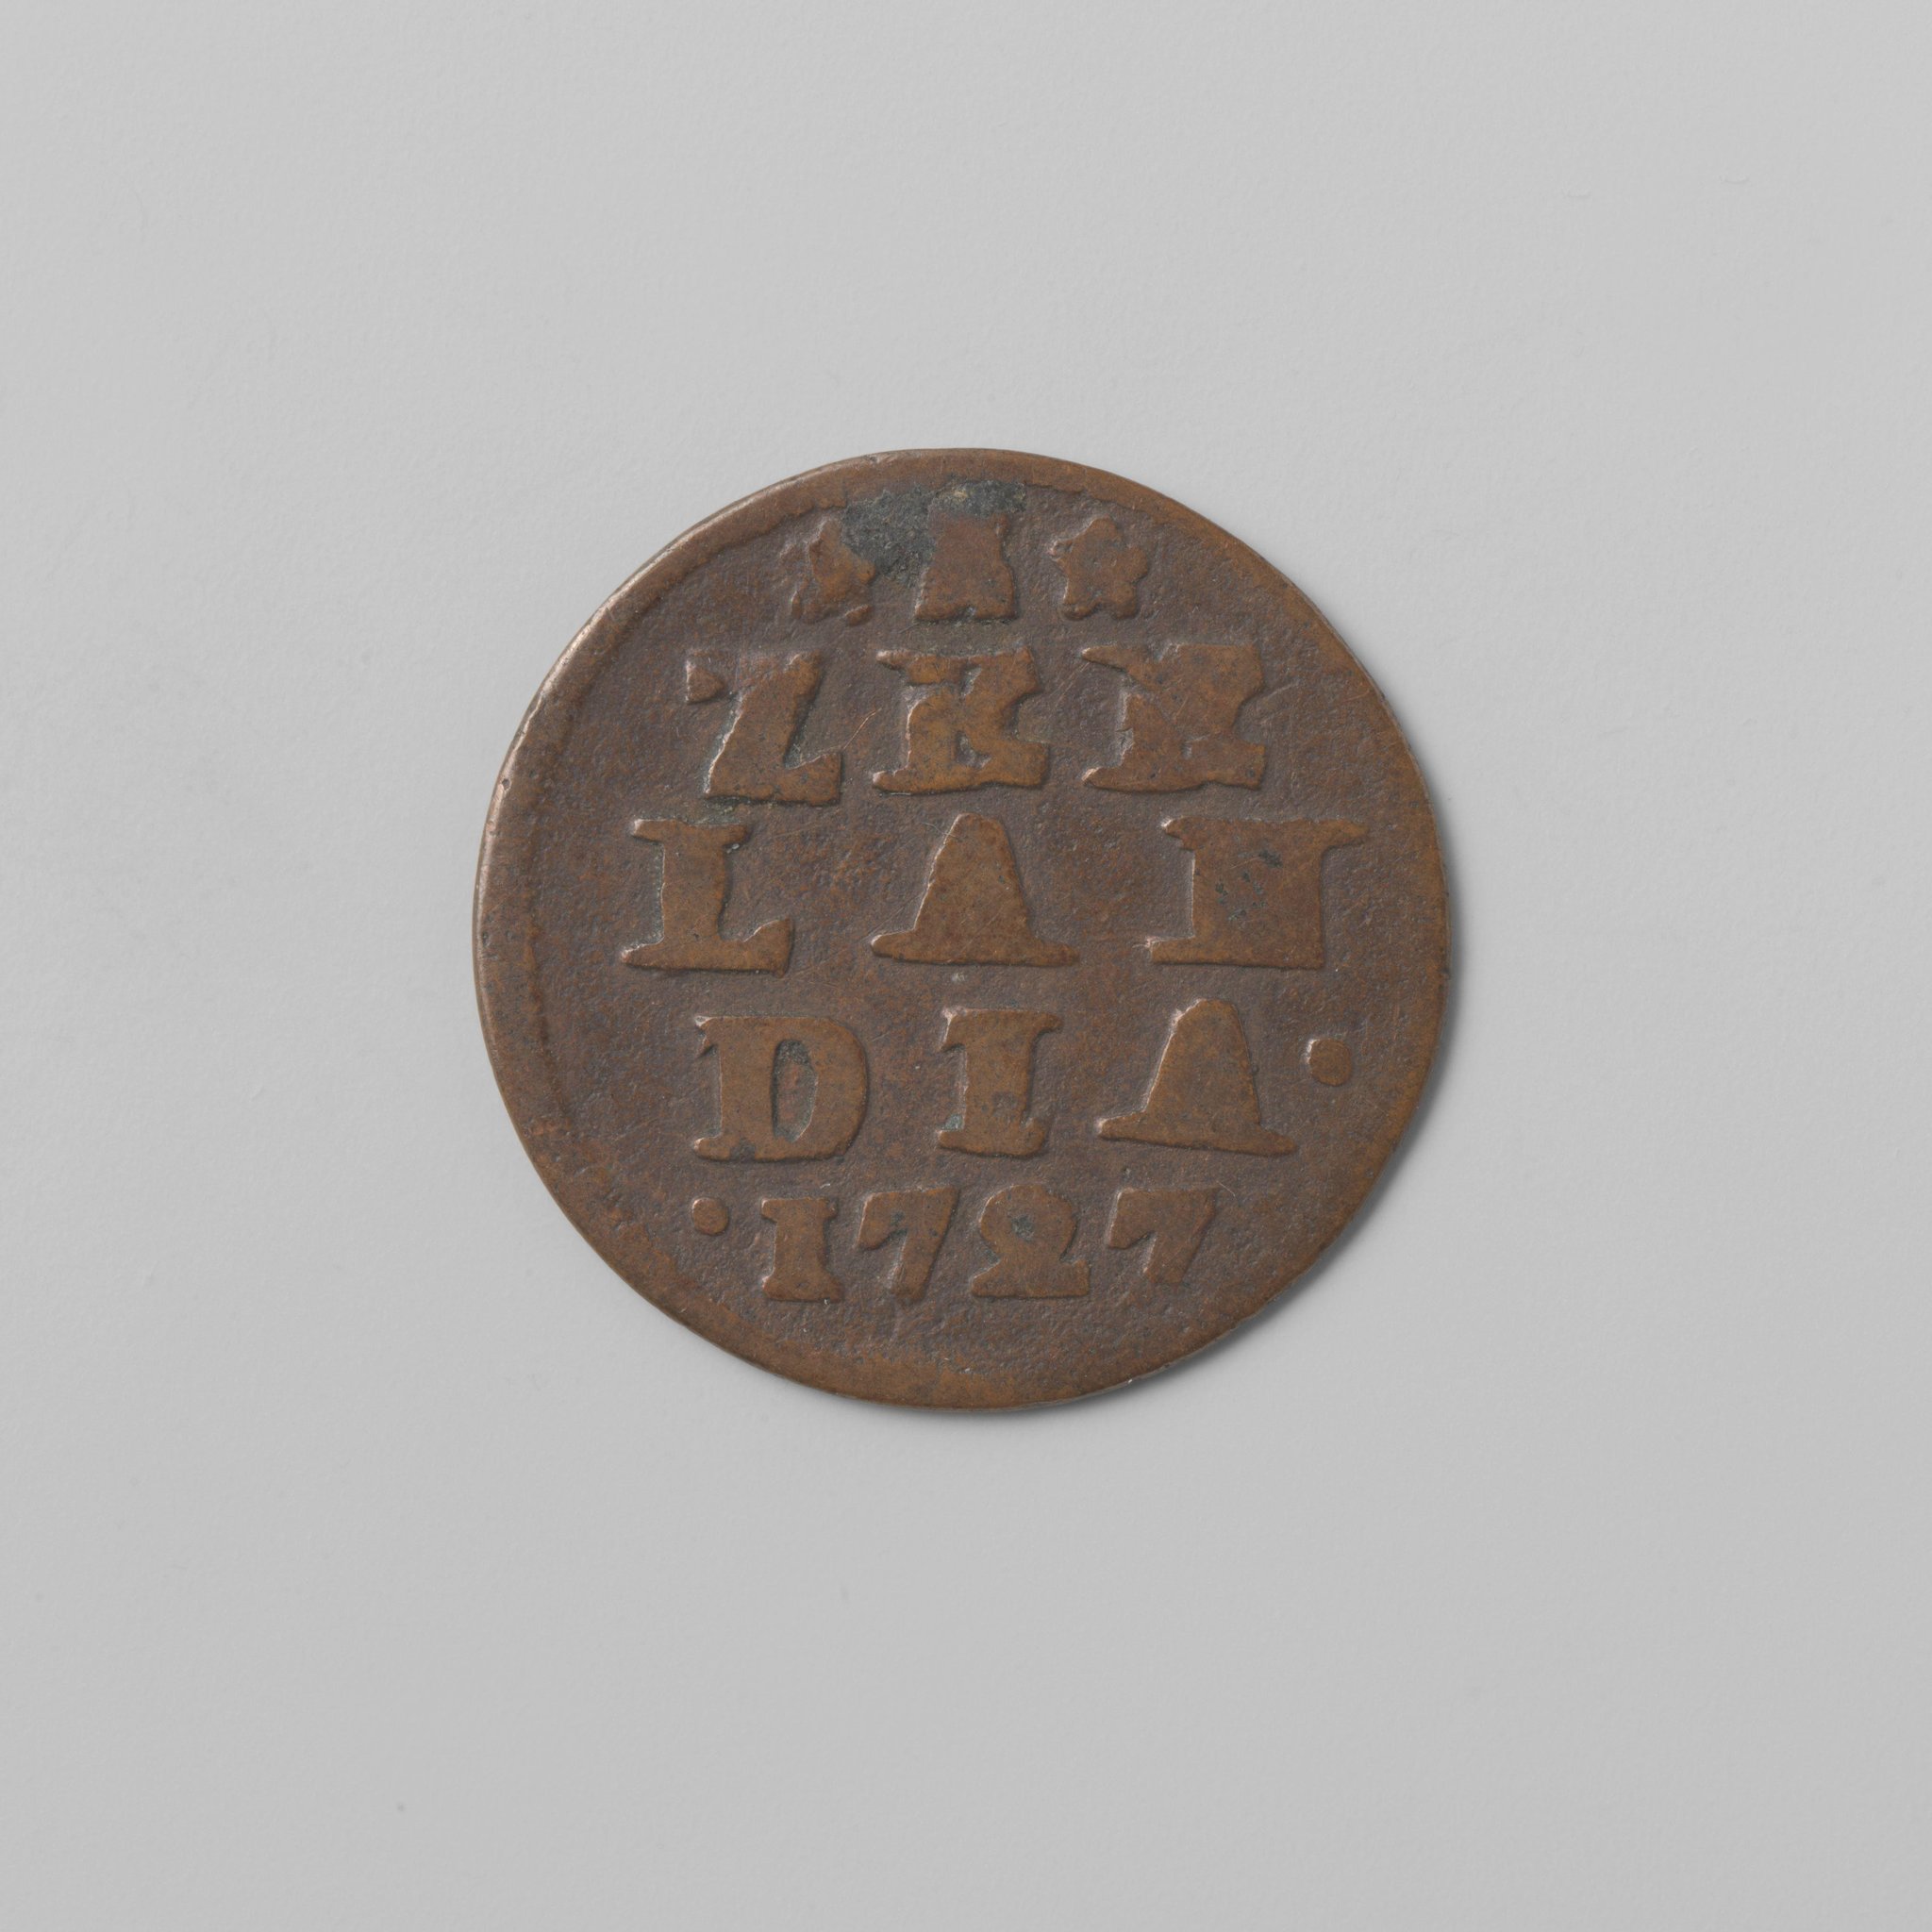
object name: coin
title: Zeeland, duit, 1727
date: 1727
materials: copper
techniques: striking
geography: middelburg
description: Koperen munt. Voorzijde: gekroond, zijdelings ingedeukt wapenschild van Zeeland. Keerzijde: opschrift in drie regels, waarboven muntteken burcht tussen twee sterren en waaronder jaartal.